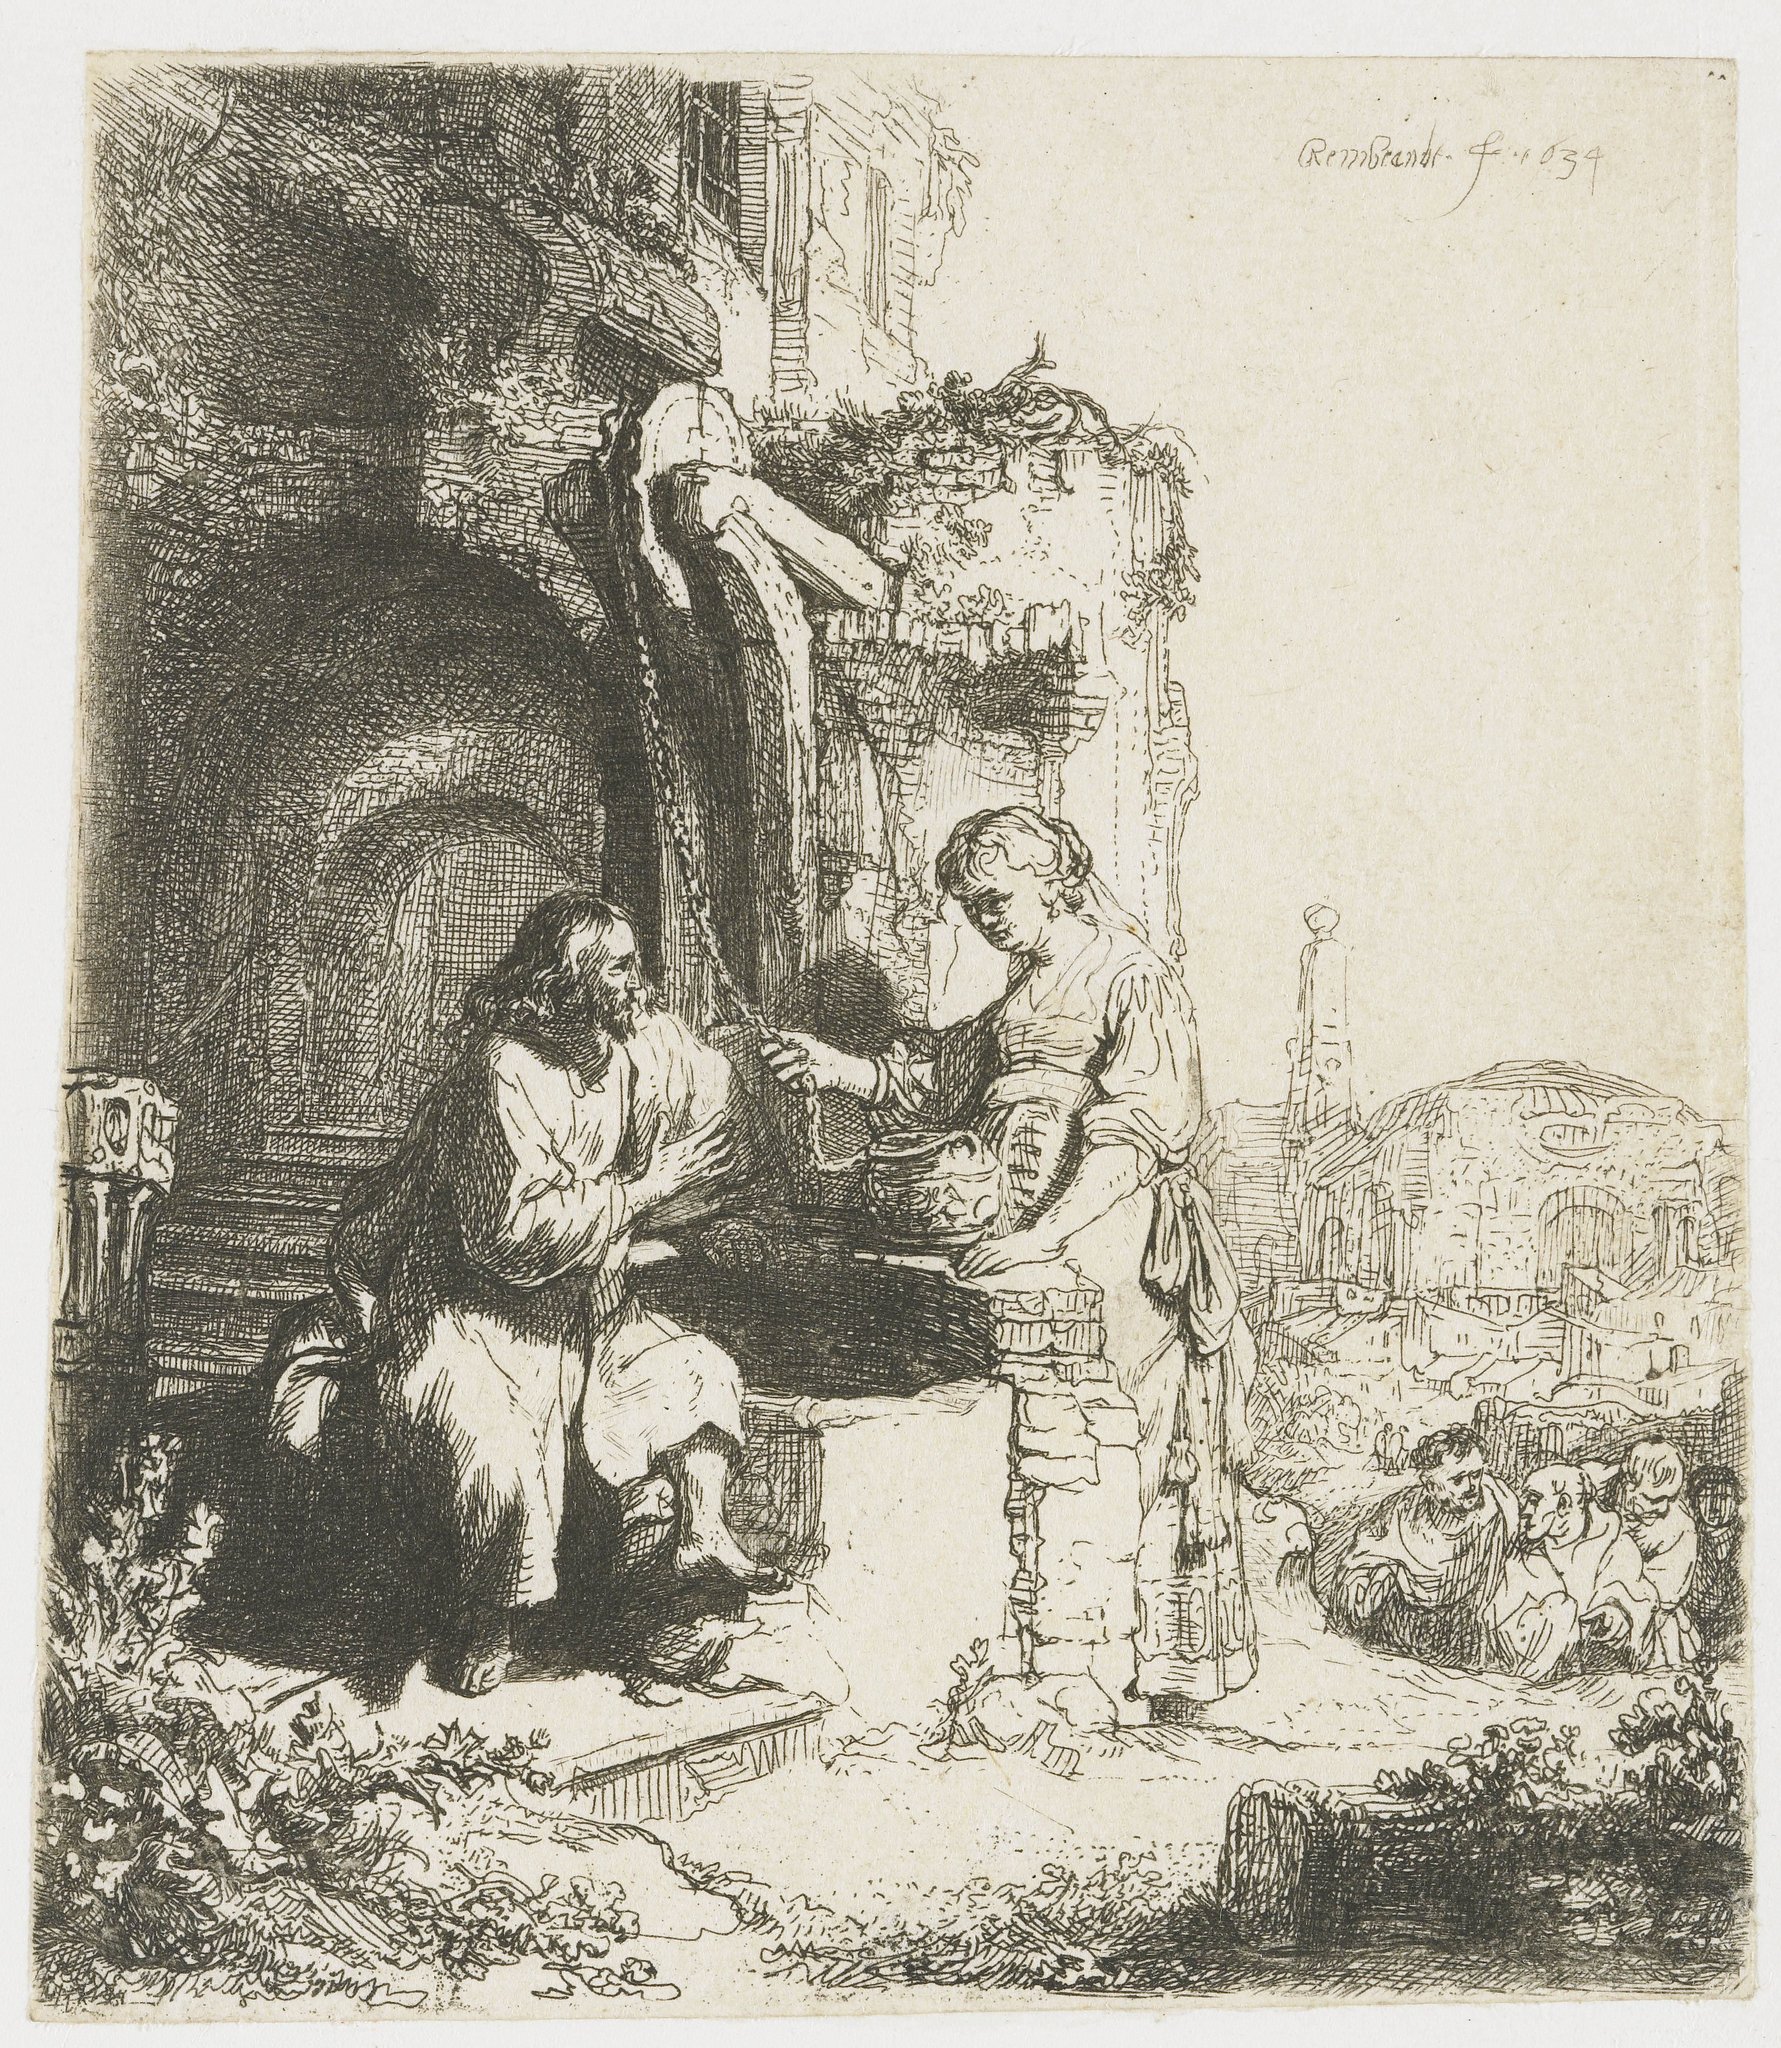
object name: print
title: Christ and the woman of Samaria among ruins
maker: rembrandt van rijn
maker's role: draughtsman, painter, print maker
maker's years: 1606-1669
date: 1634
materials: paper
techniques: etching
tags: the woman of samaria (john 4:4-42)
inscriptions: mark: Lugt 2228, mark: Lugt 2760, signature and date: ‘Rembrandt f. 1634’